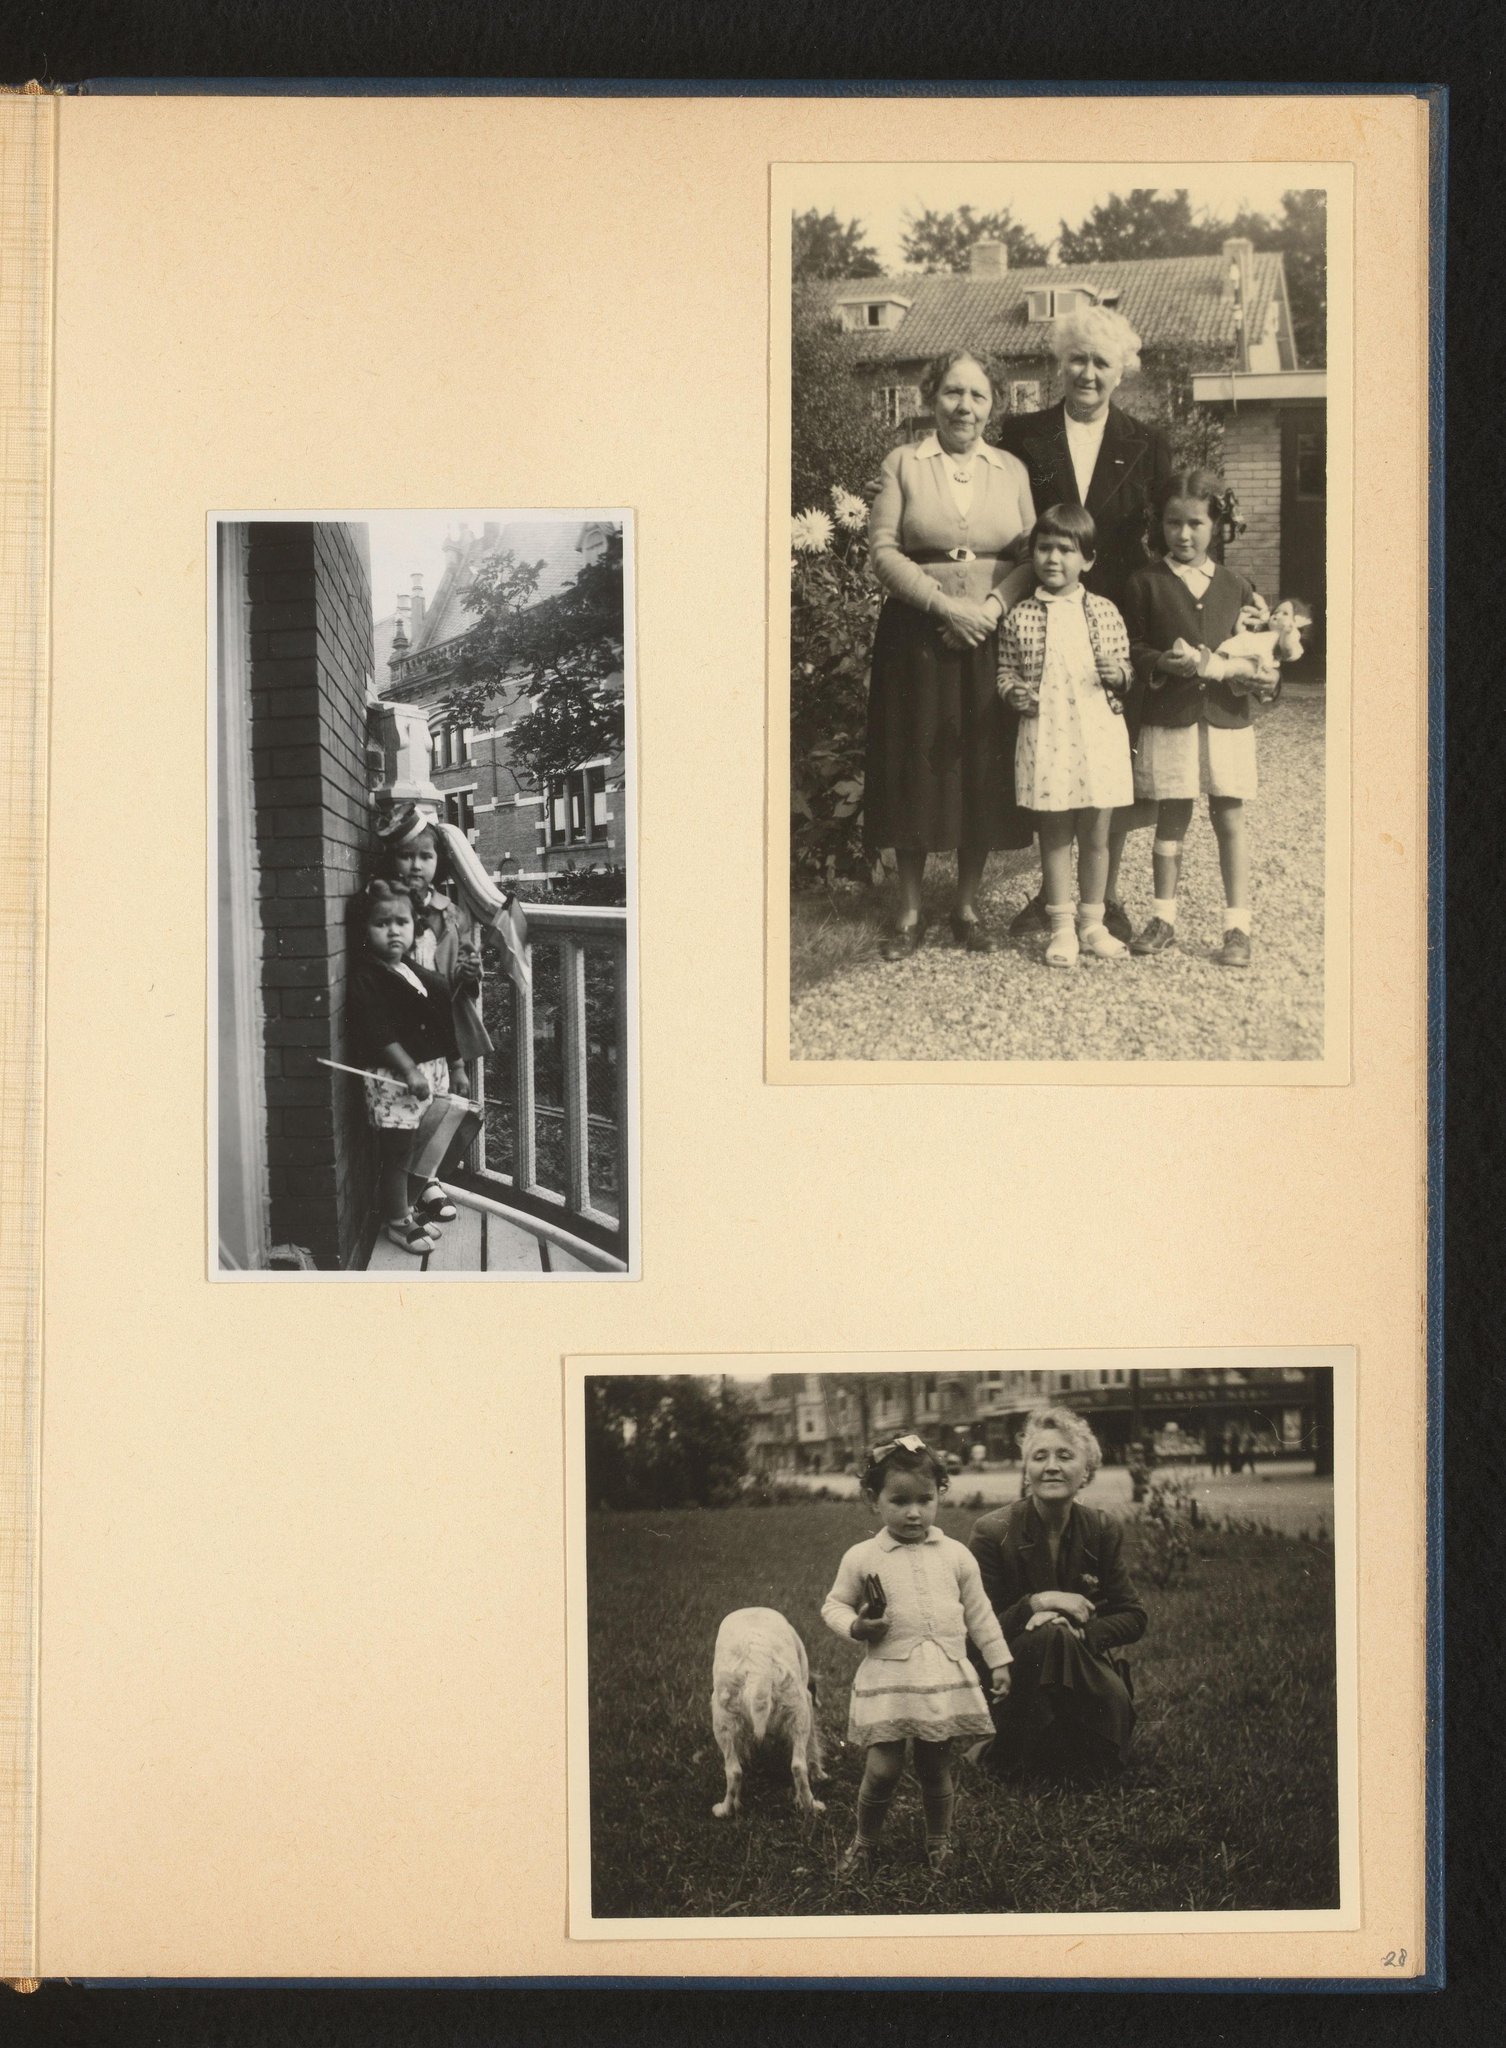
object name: photograph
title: Dochters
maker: Anonymous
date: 1946-1952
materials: cardboard, photographic support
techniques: gelatin silver print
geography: netherlands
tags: surabaya, paris, beatrice jacqueline eveline dumas, historical persons - bb - woman, playing toddler; child amusing itself - aa - girl, historical persons, netherlands, dutch east indies, the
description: Blad met drie foto's van de twee dochters van Eef Dumas, met twee oudere vrouwen, op het balkon en met een hond. Onderdeel van het fotoalbum van Beatrice Jacqueline Eveline (Eef) Dumas, ca. 1880-1952.